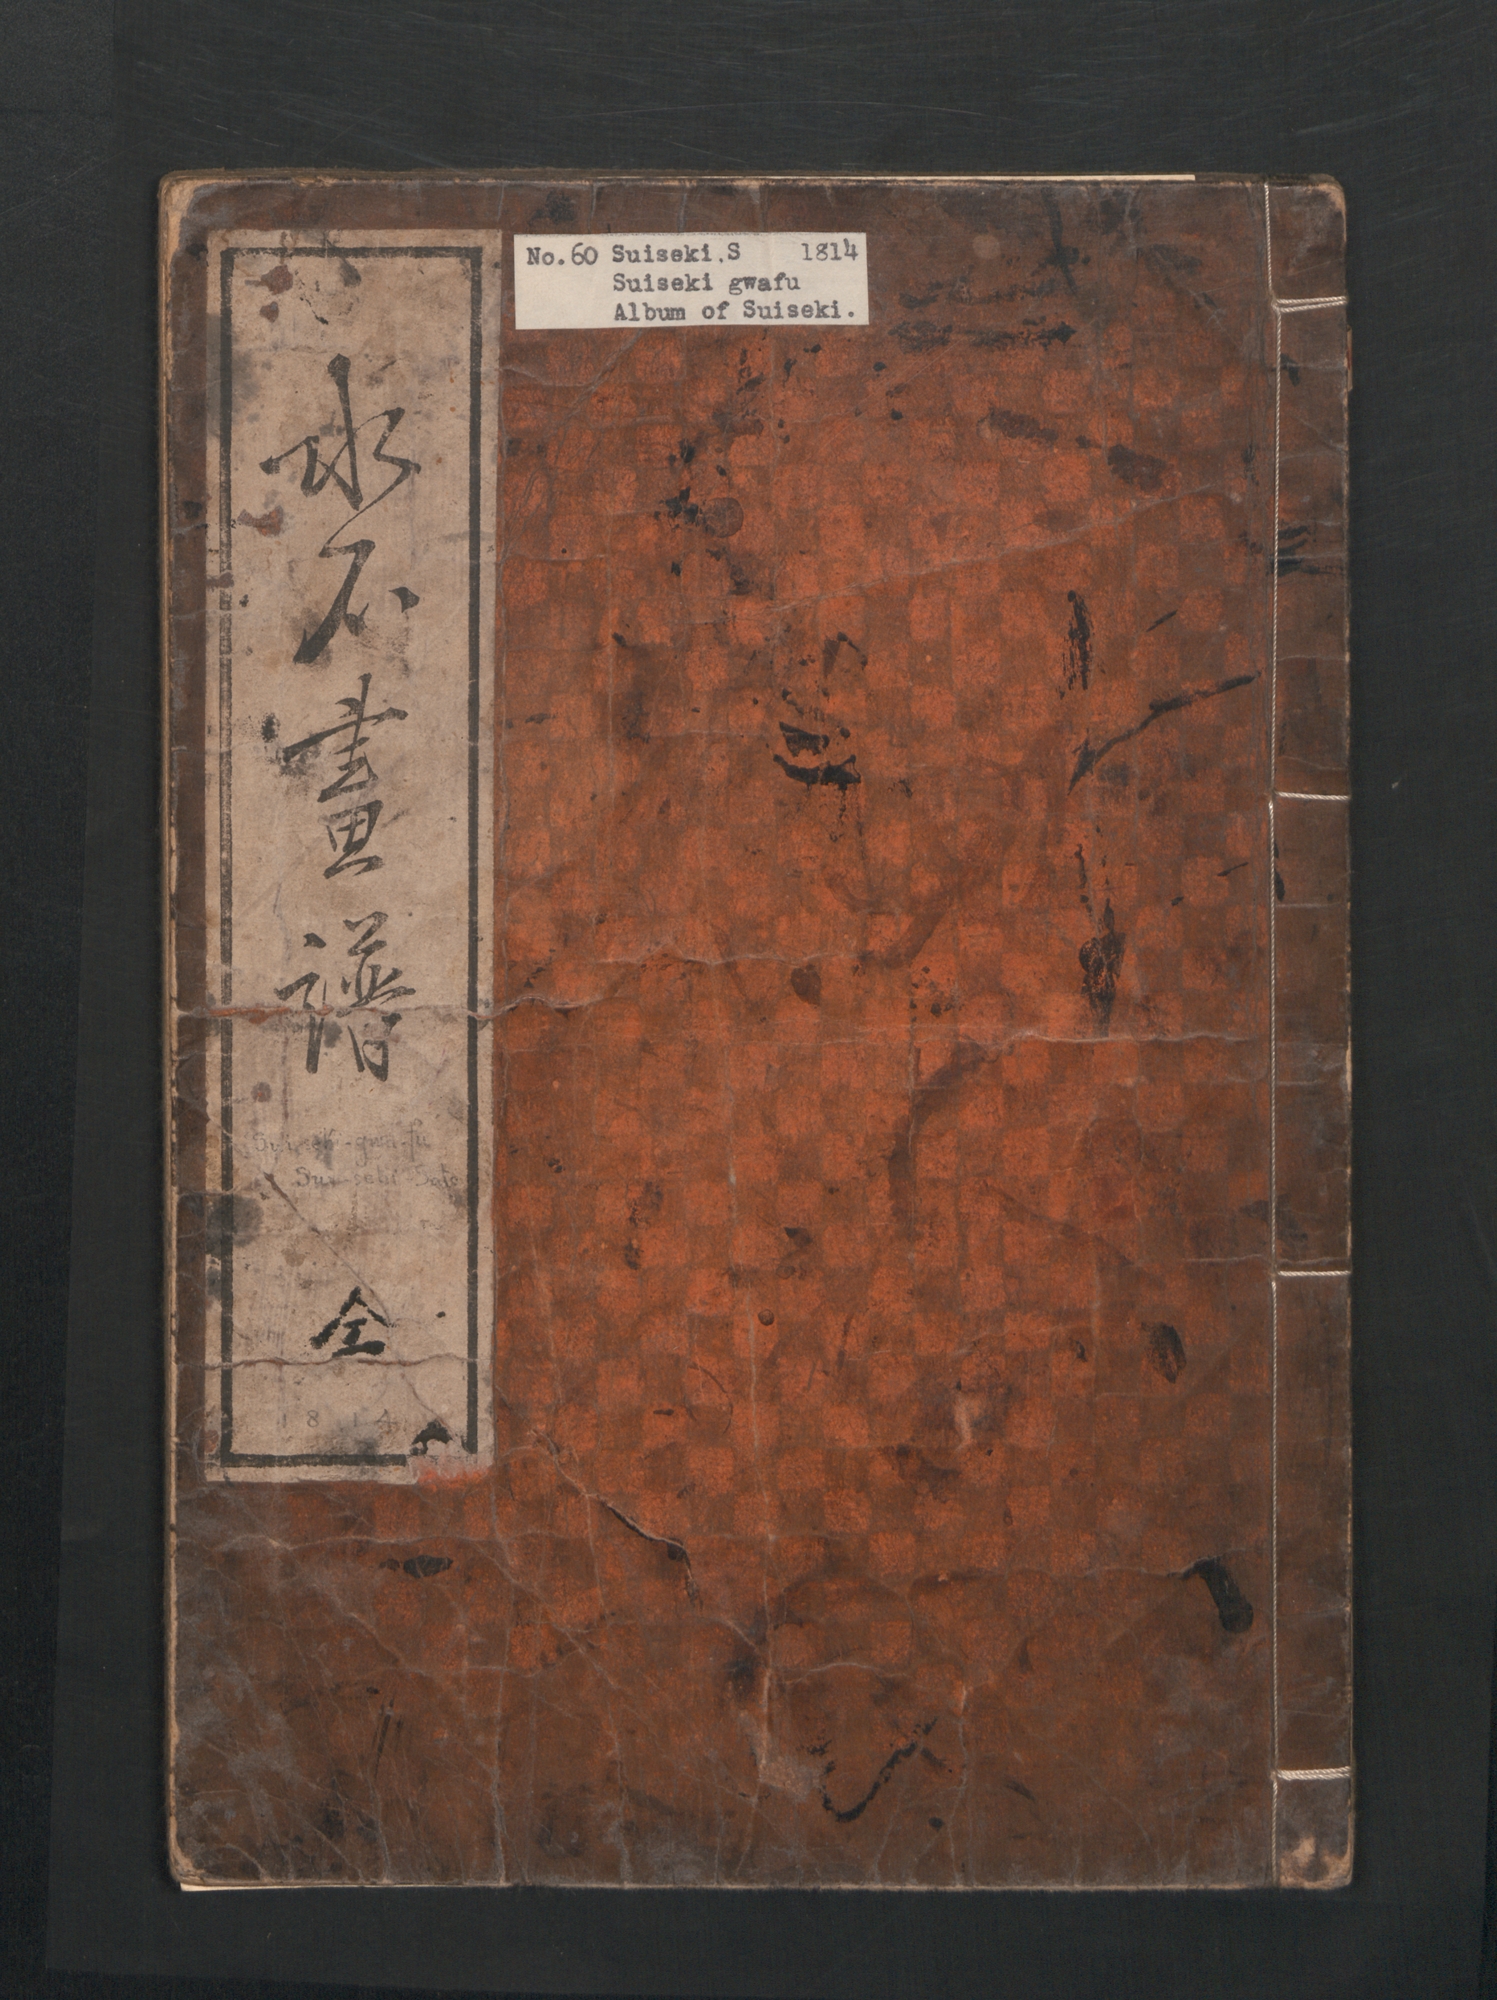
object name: illustrated book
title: Suiseki Picture Album (Suiseki gafu) 水石画譜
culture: japanese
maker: satō suiseki 佐藤水石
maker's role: artist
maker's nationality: japanese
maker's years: 1806-1840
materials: ink, paper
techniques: woodblock print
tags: men